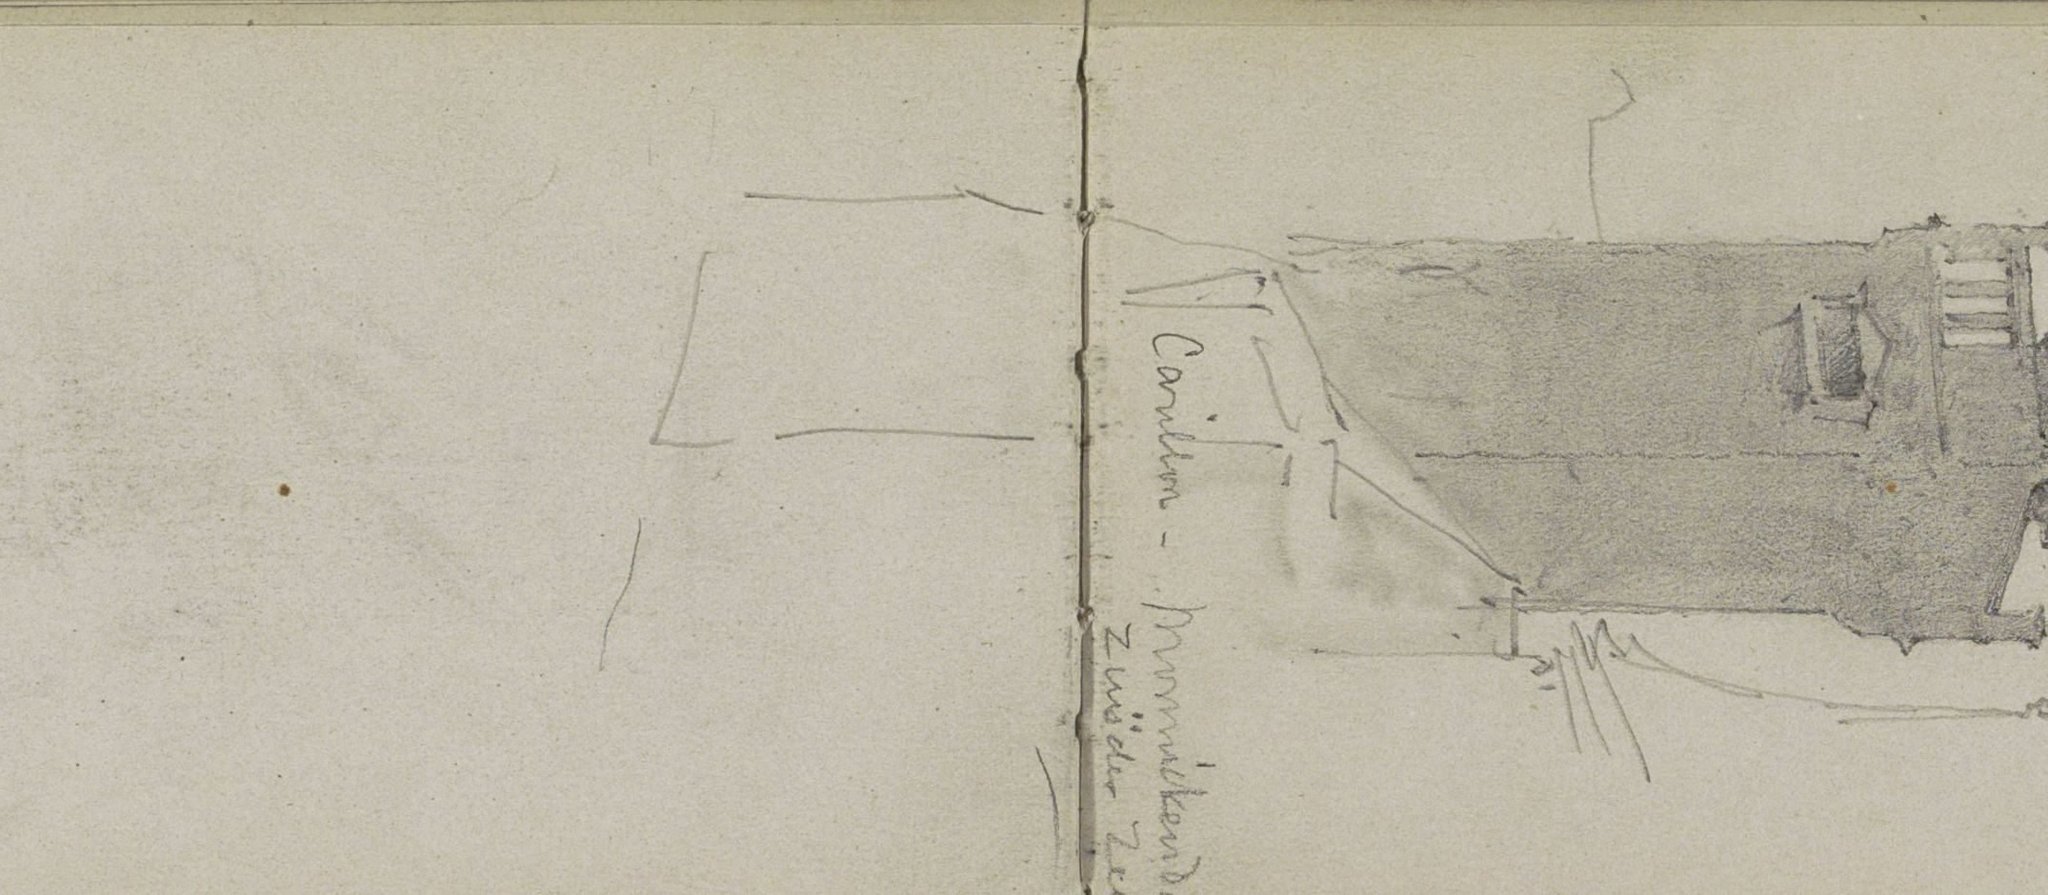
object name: sketchbook leaf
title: Speeltoren met carillon van Monnickendam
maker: george clausen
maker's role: draughtsman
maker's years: 1852-1912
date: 1875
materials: paper, pencil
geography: monnickendam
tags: carillon, chimes, tower (of house or building)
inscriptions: annotation: ‘carillon - Monnickendam/ Zuider Zee’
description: Blad 26 verso en 27 recto uit een schetsboek met 46 bladen.